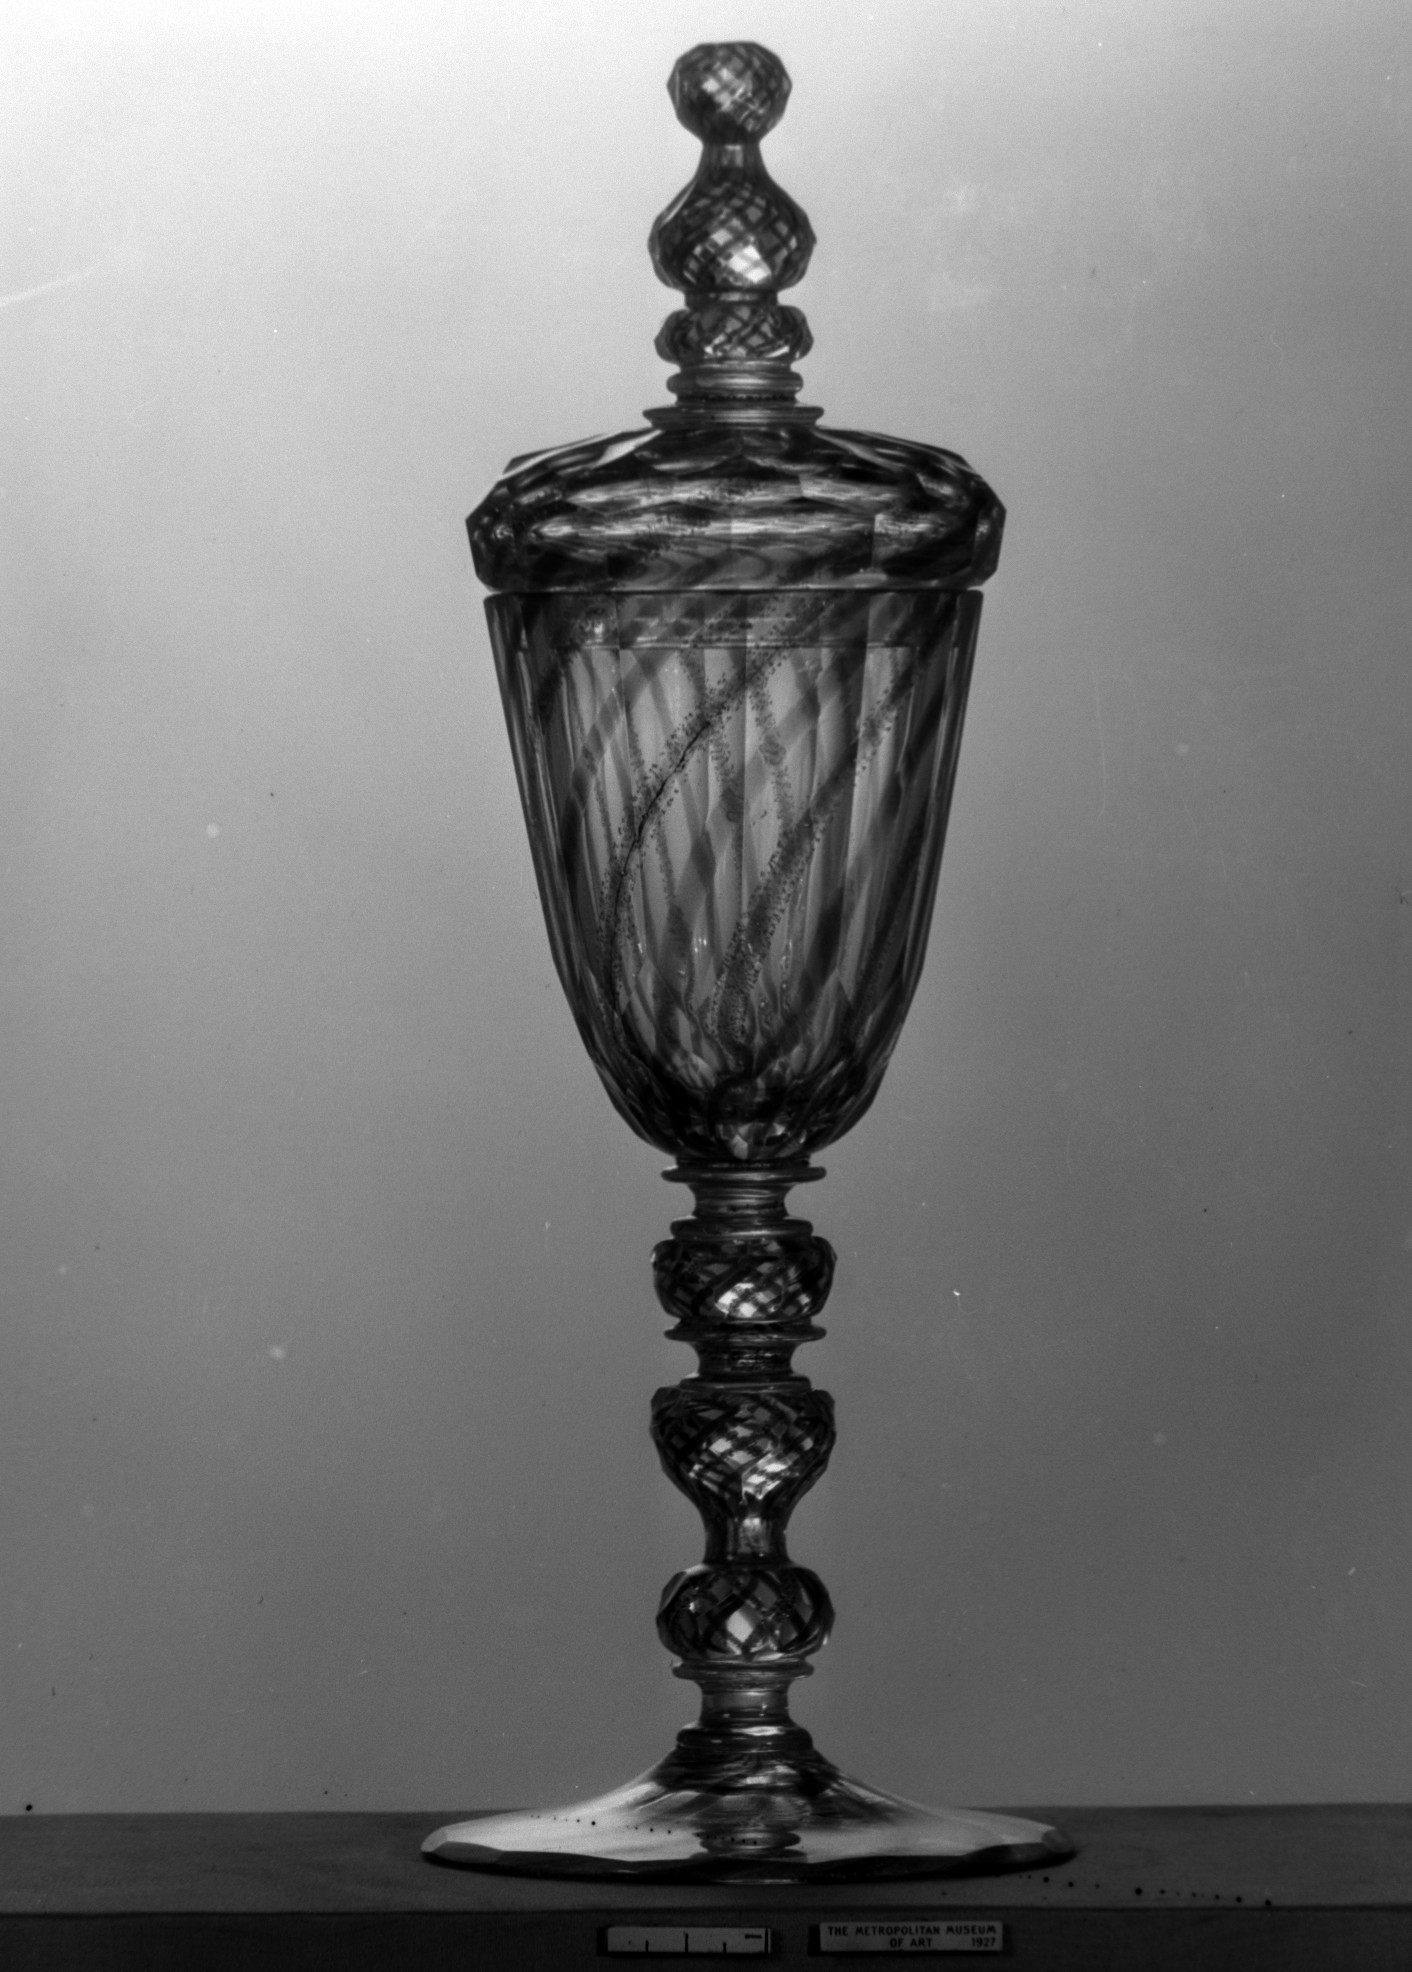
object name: standing cup with cover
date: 1701-1750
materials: glass